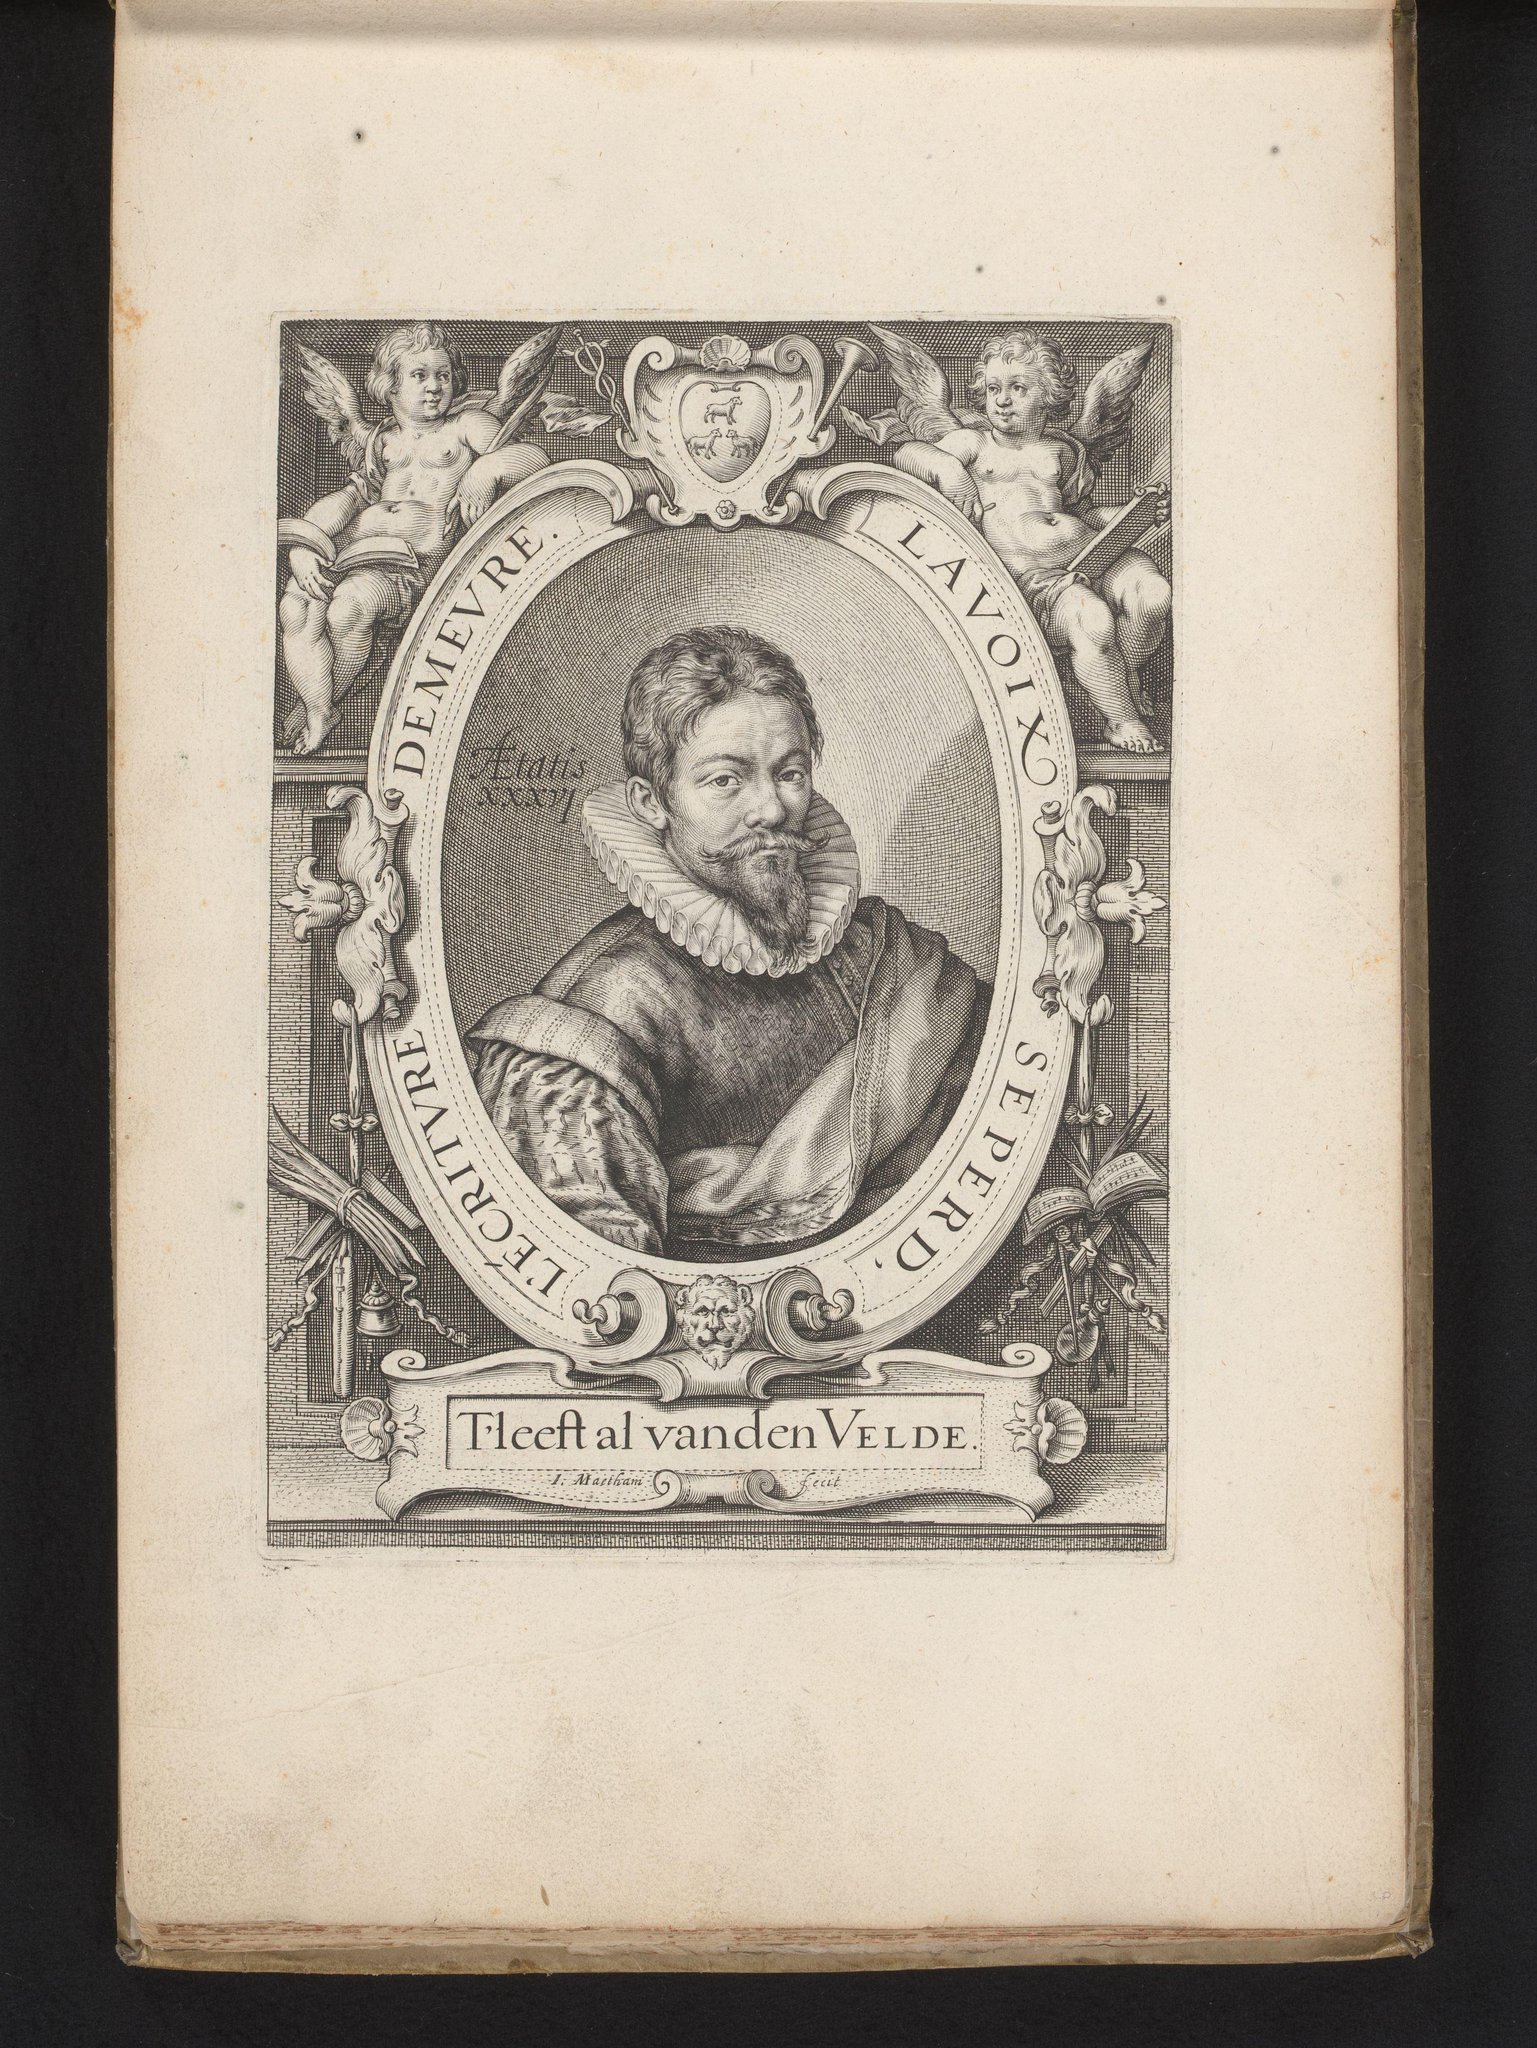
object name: album leaf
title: Spieghel der schrijfkonste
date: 1605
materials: paper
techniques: engraving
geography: haarlem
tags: haarlem, painter, jan van de velde (i)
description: Portret van de kalligraaf Jan van den Velde op 36-jarige leeftijd in een ovale omlijsting met het randschrift: La voix se perd, l'écriture demeure. Bovenaan zijn wapenschild, een veld met drie schapen, en eronder zijn wapenschild: T'leeft al vanden Velde. Daarnaast een caduceus en loftrompet. Links en rechts een putti met schrijfbenodigdheden. De prent maakt deel uit van een album.